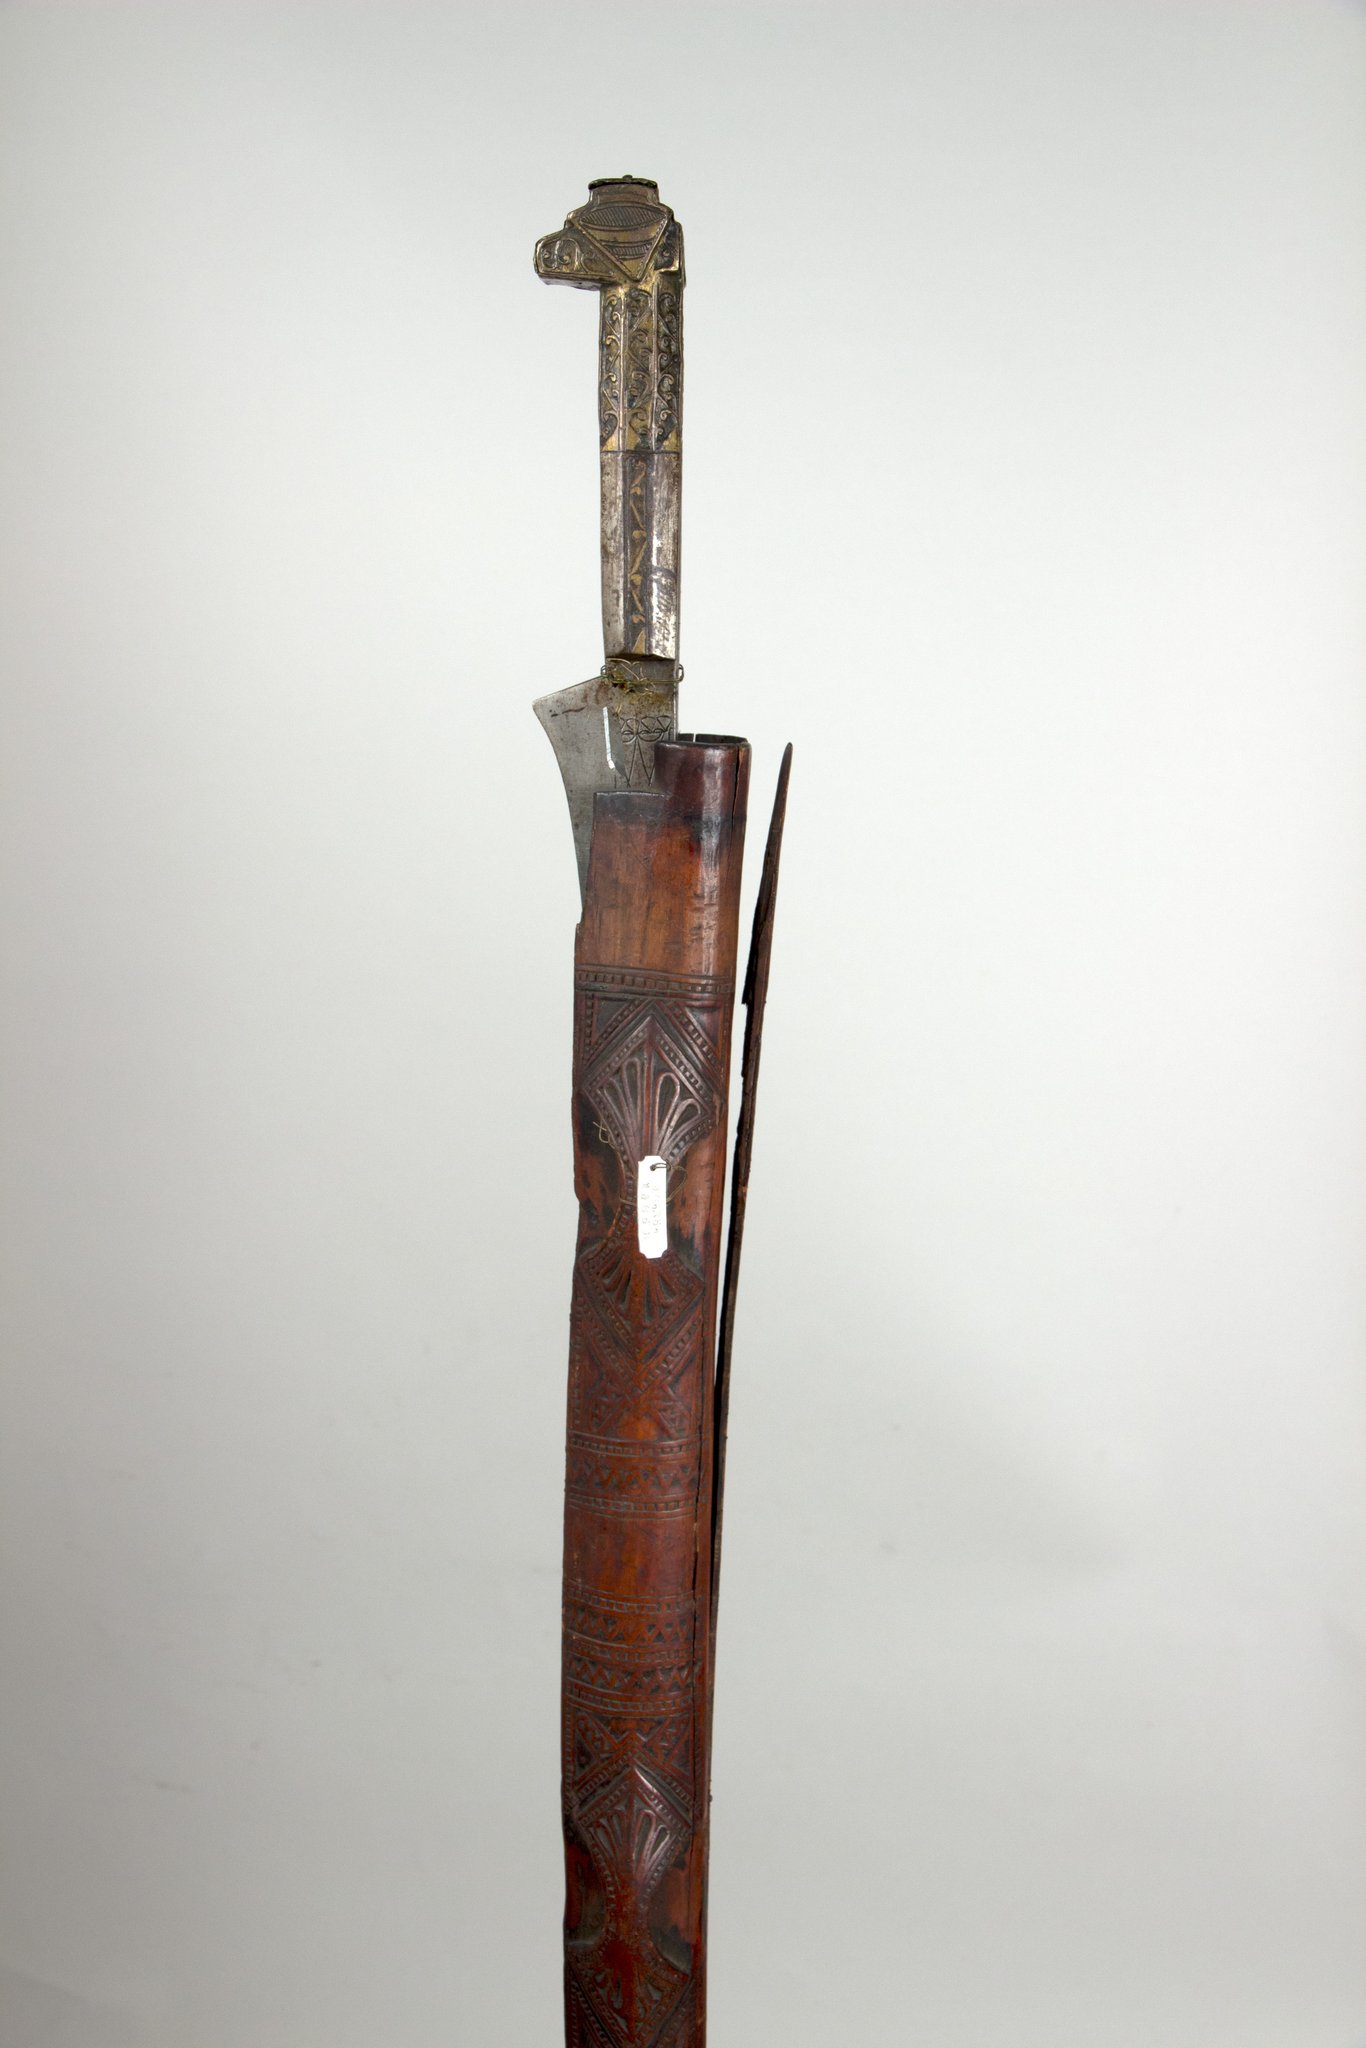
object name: sword flyssa with scabbard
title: Sword (Flyssa) with Scabbard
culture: algerian or kabyle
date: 1701-1900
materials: brass, iron, steel, wood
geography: algeria